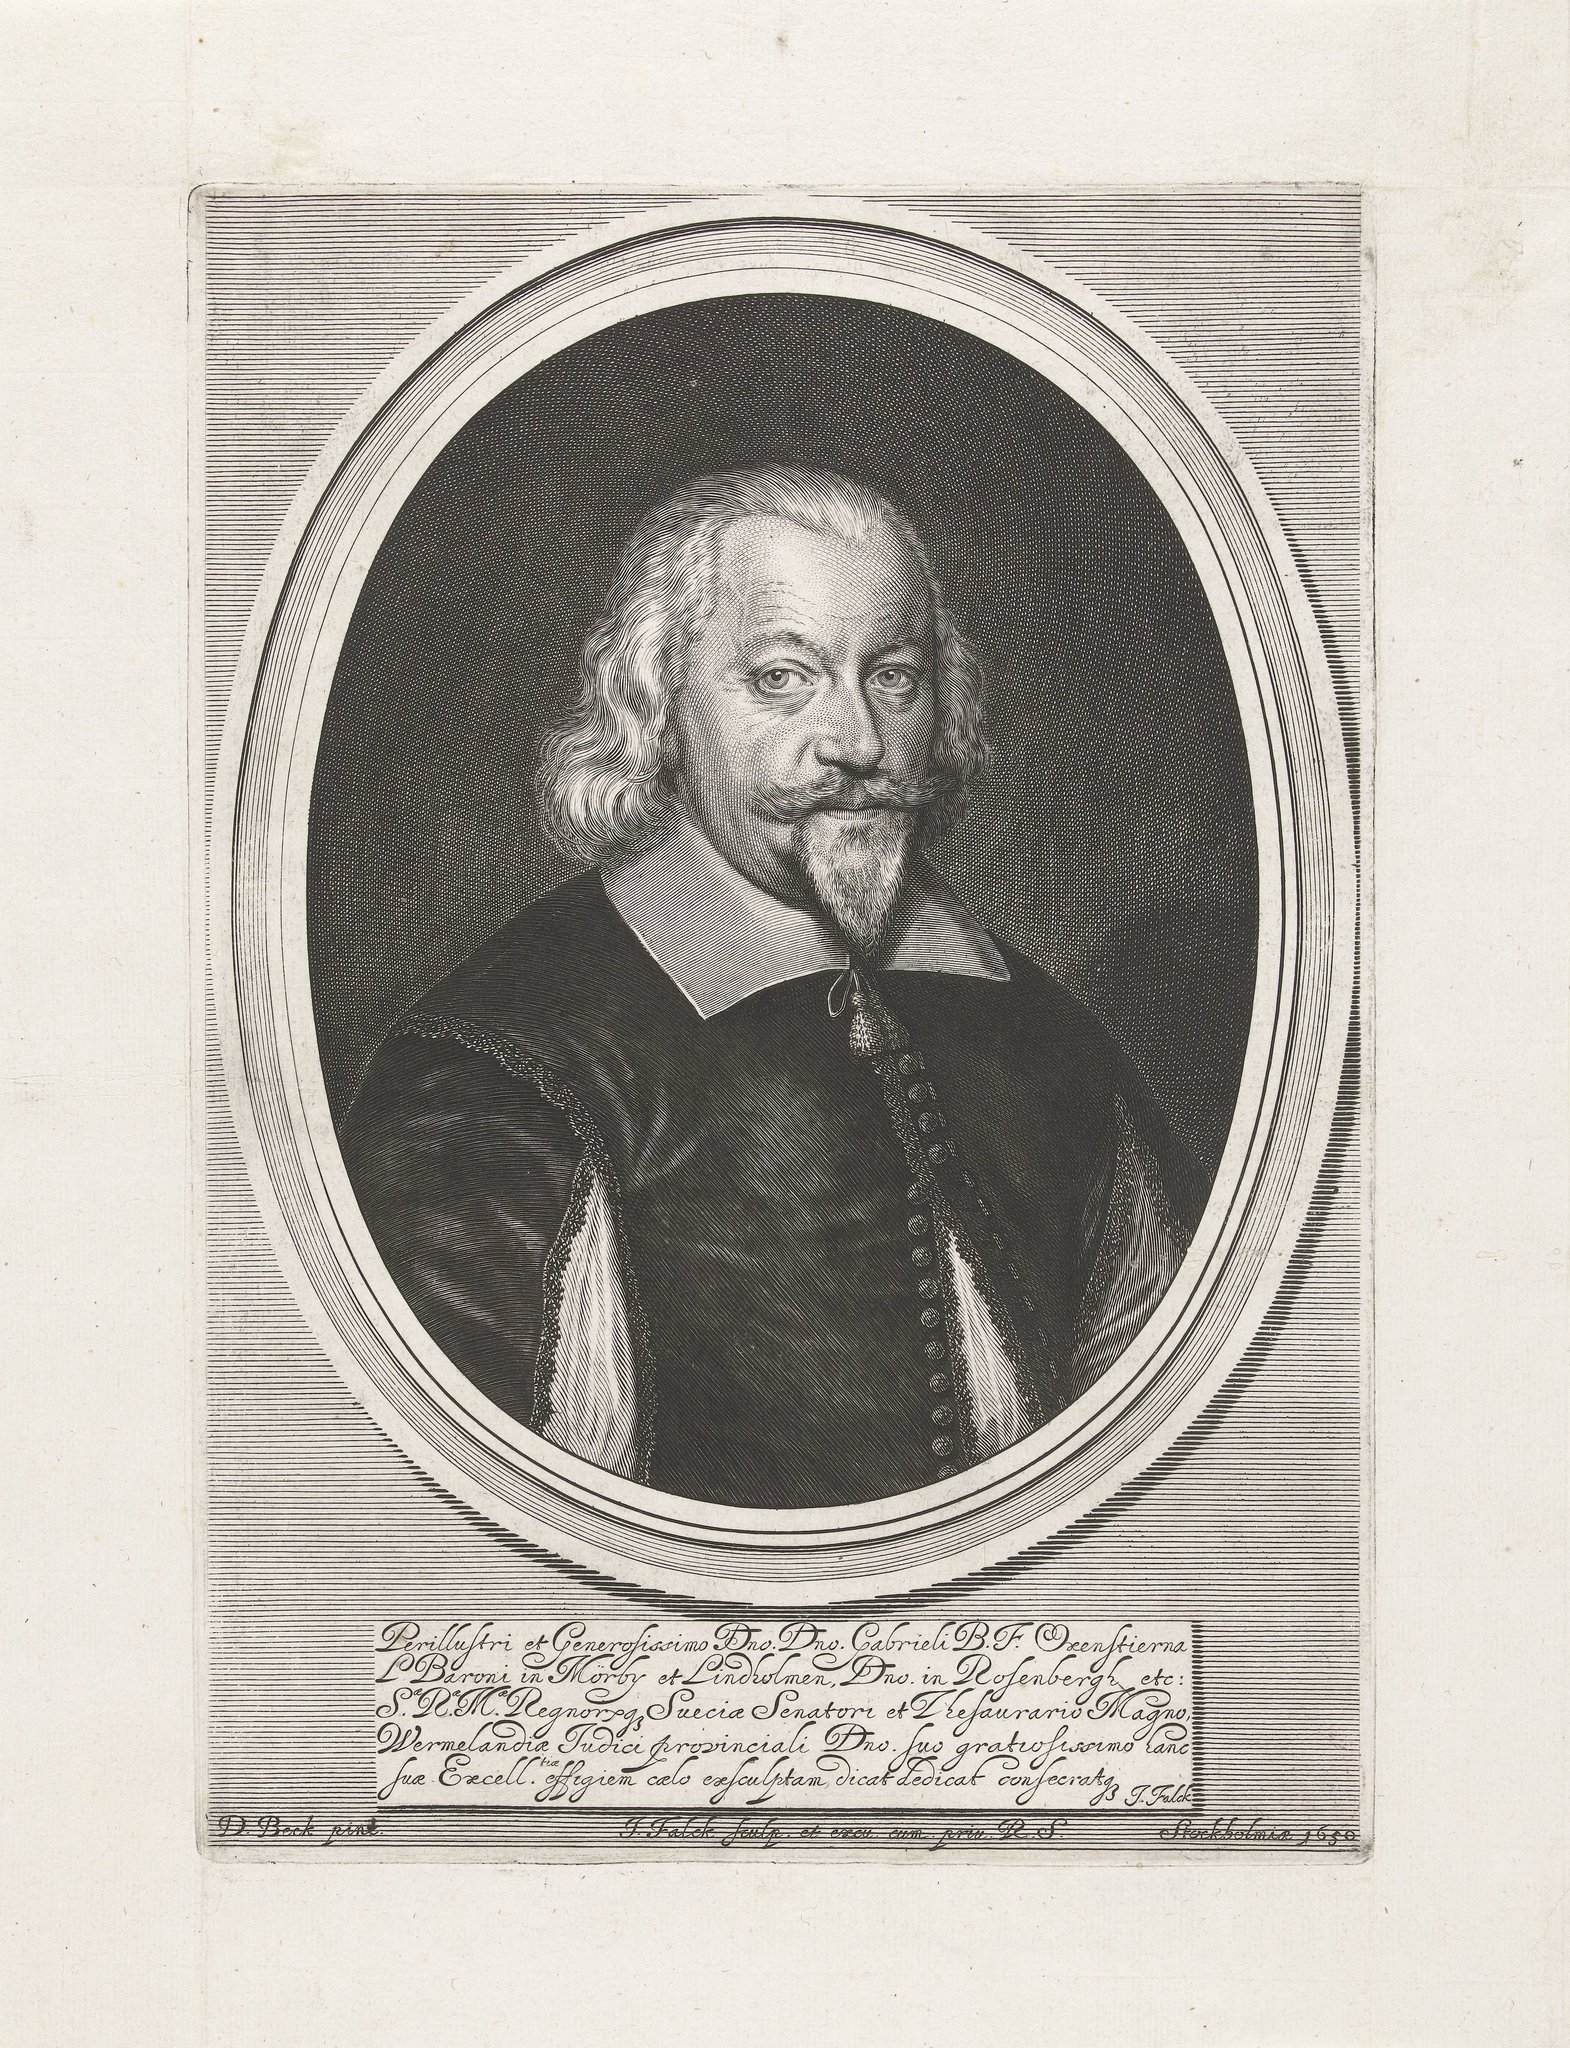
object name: print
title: Portret van Gabriel Oxenstierna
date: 1650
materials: paper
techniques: engraving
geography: stockholm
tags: gabriel oxenstierna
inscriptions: collector's mark: Lugt 240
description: Busteportret van de Zweed Gabriel B.F. Oxenstierna, in ovale omlijsting met onderschrift in Latijn.